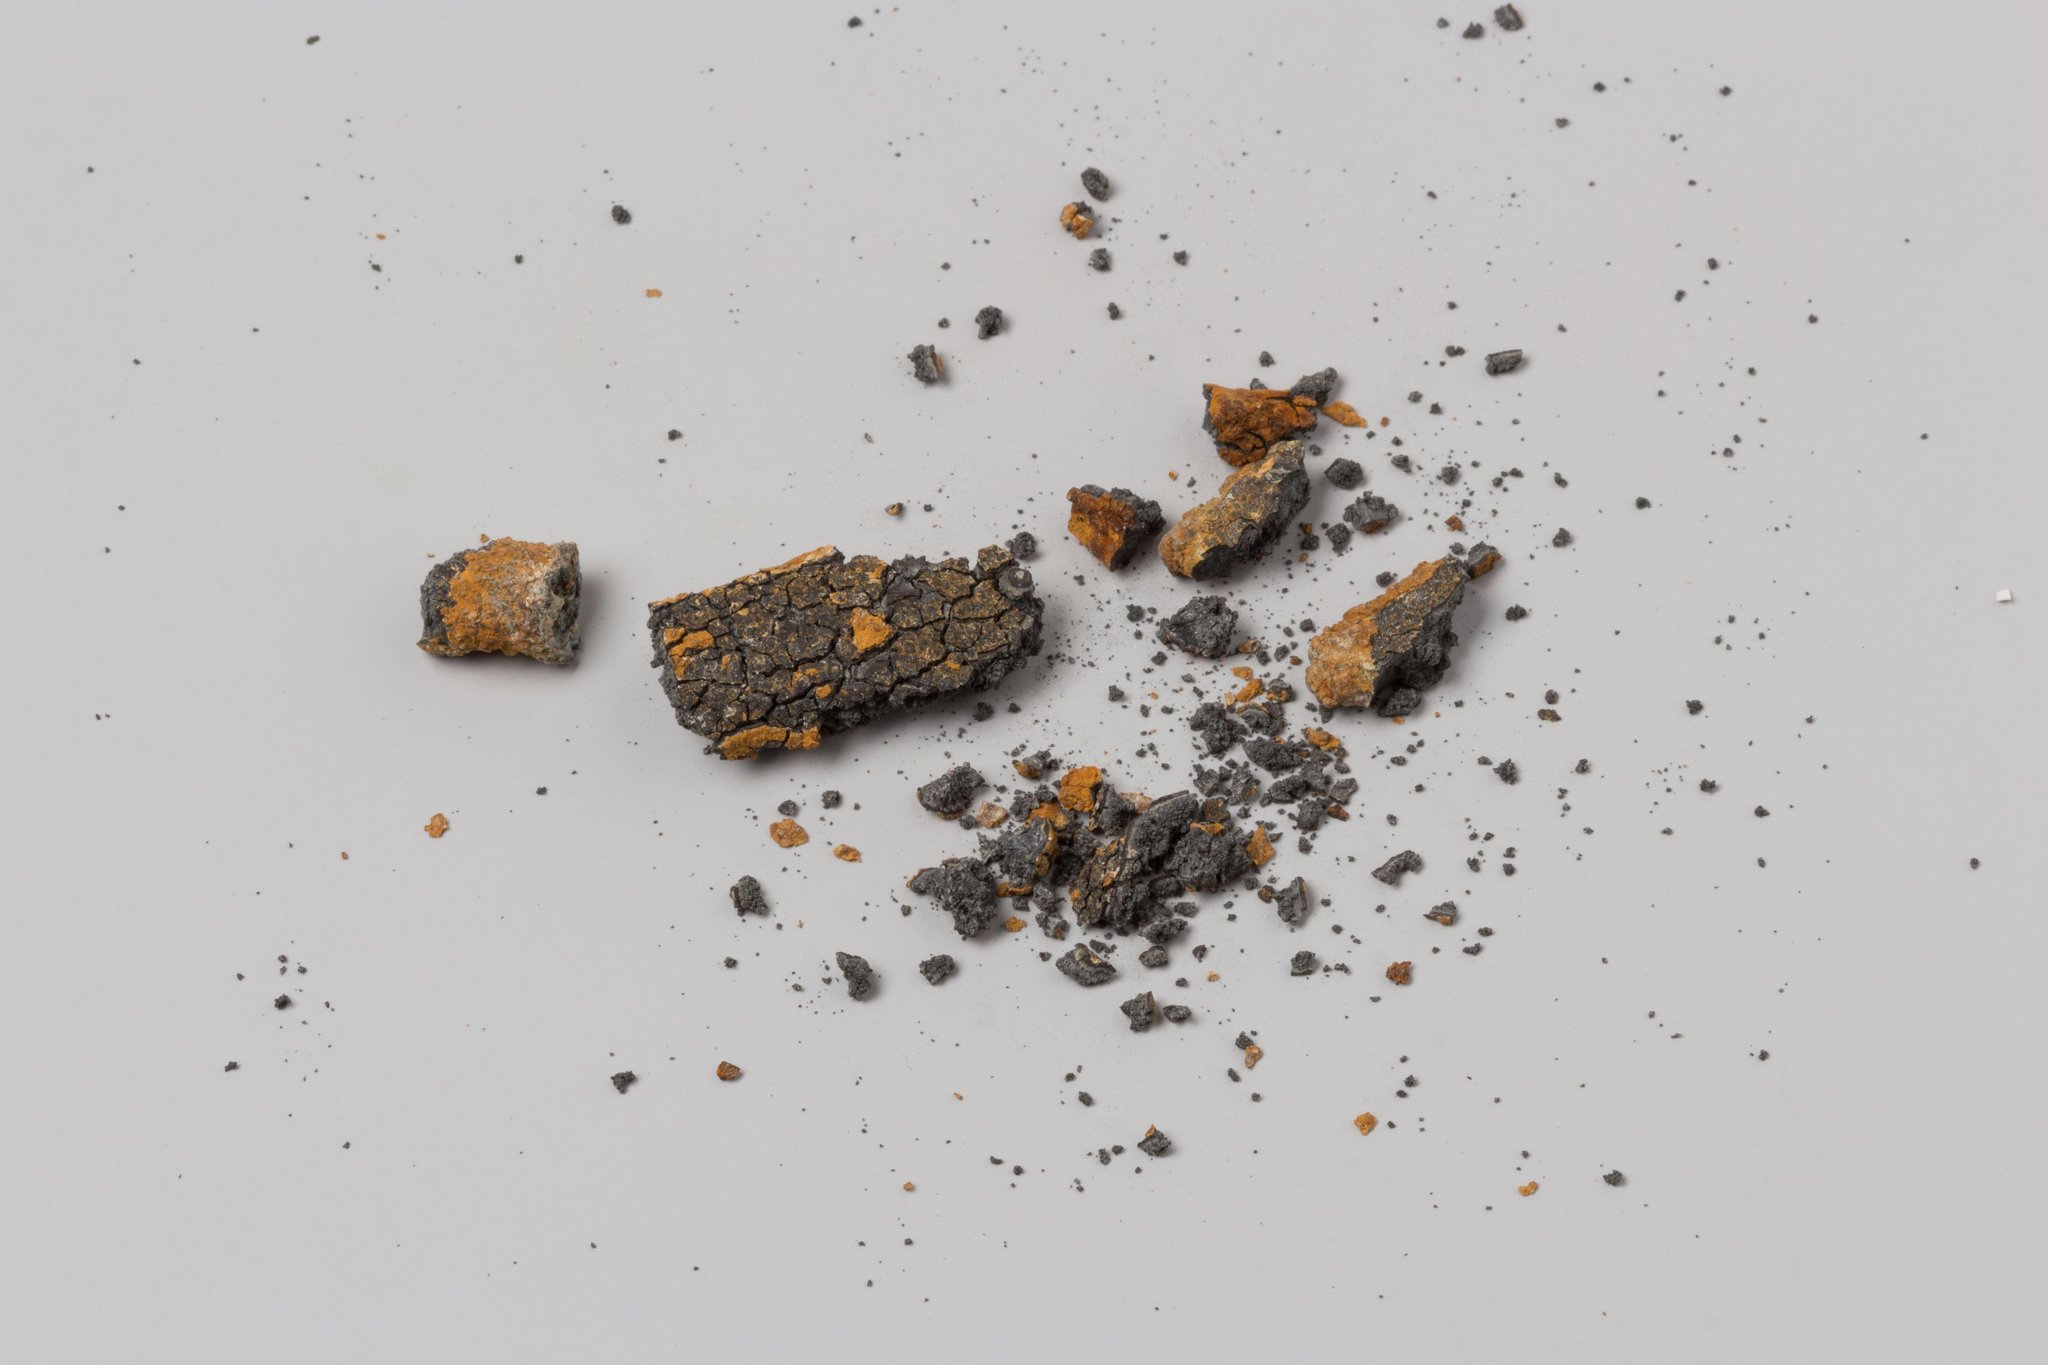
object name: fork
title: Gefragmenteerde steel van vork of lepel uit het wrak van de Oost-Indiëvaarder Hollandia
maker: Anonymous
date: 1700-1743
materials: tin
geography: netherlands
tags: verenigde oostindische compagnie, hollandia (schip), annet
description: Cutlery, fragment: stem of fork or spoon; fragm, id. NG 1980-27H49a.